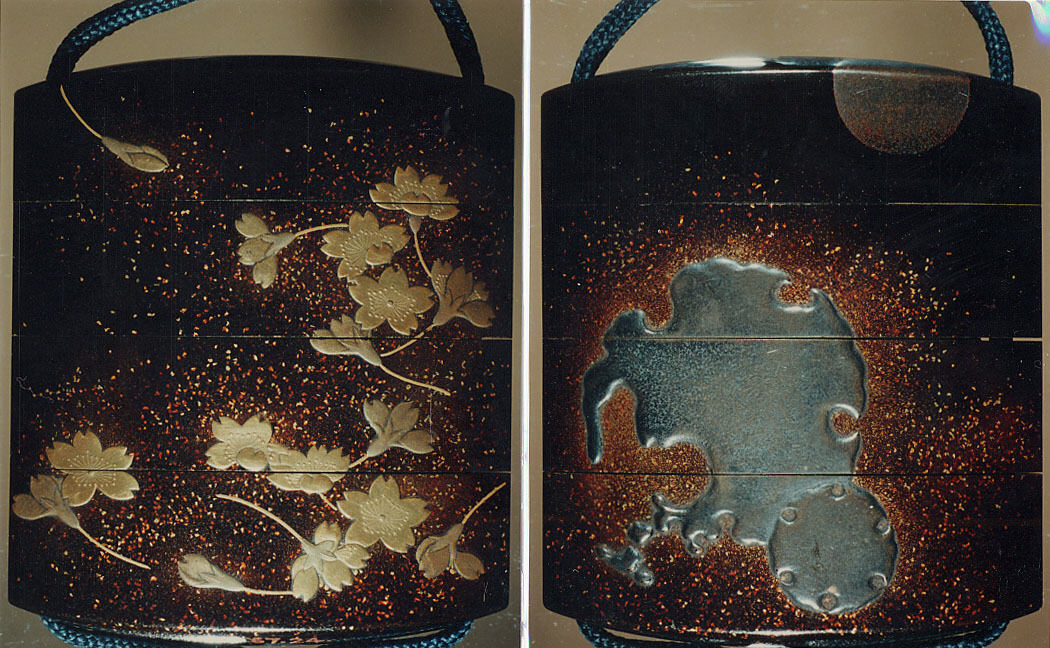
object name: inrō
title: Case (Inrō) with Design of Scattered Cherry Blossoms (obverse); Snow Roundels (reverse)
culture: japanese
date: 1801-1900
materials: gold, lacquer, silver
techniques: fundame, hiramakie, roiro, maki-e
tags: flowers